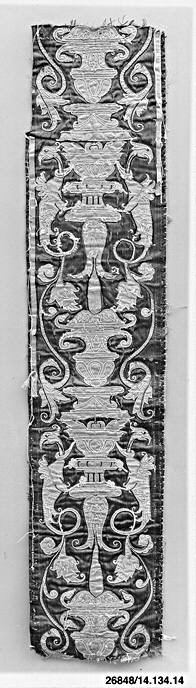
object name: orphrey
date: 1601-1700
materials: silk